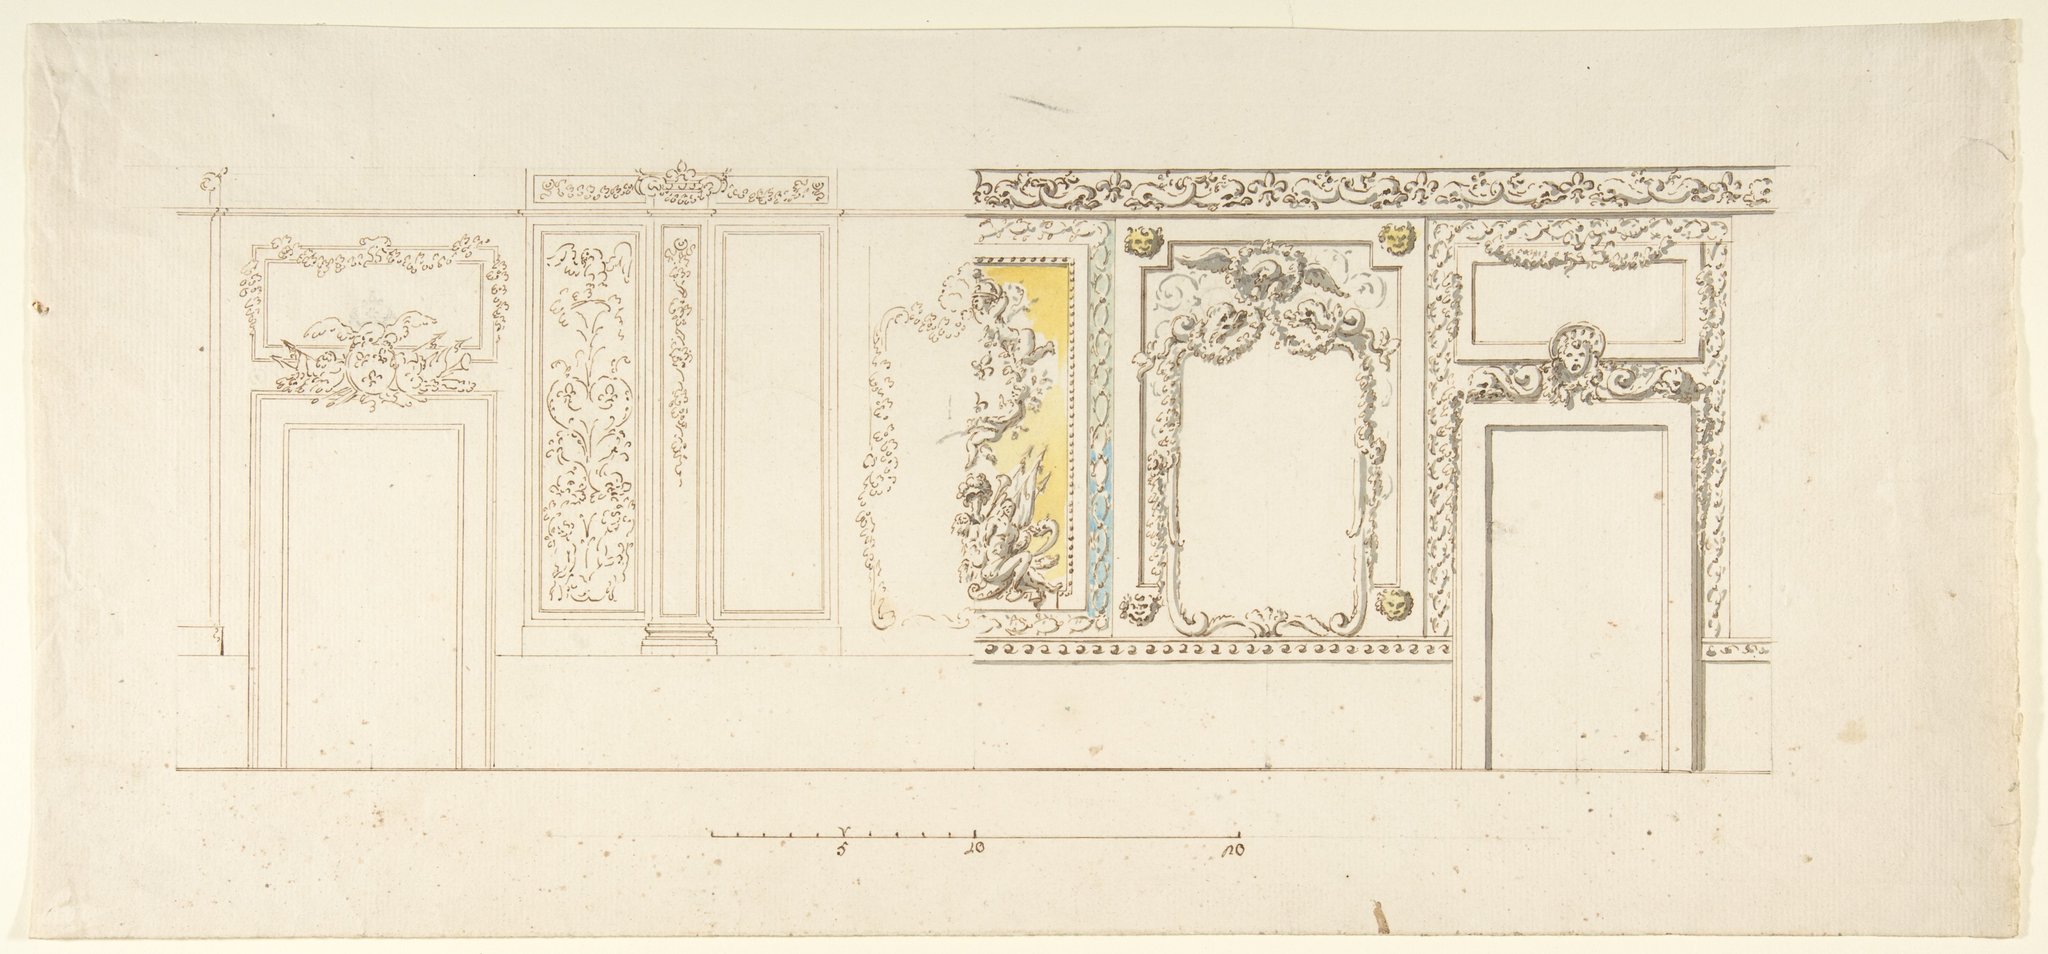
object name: drawing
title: Design for an Interior Wall Decoration of a Palazzo with Two Doorways and a Decorated Panelling with Trophies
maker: anonymous, italian, 18th century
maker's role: artist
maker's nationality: italian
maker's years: 1700-1800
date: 1701-1800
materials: chalk, ink, paper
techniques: brush, pen, wash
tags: doorways,trophies